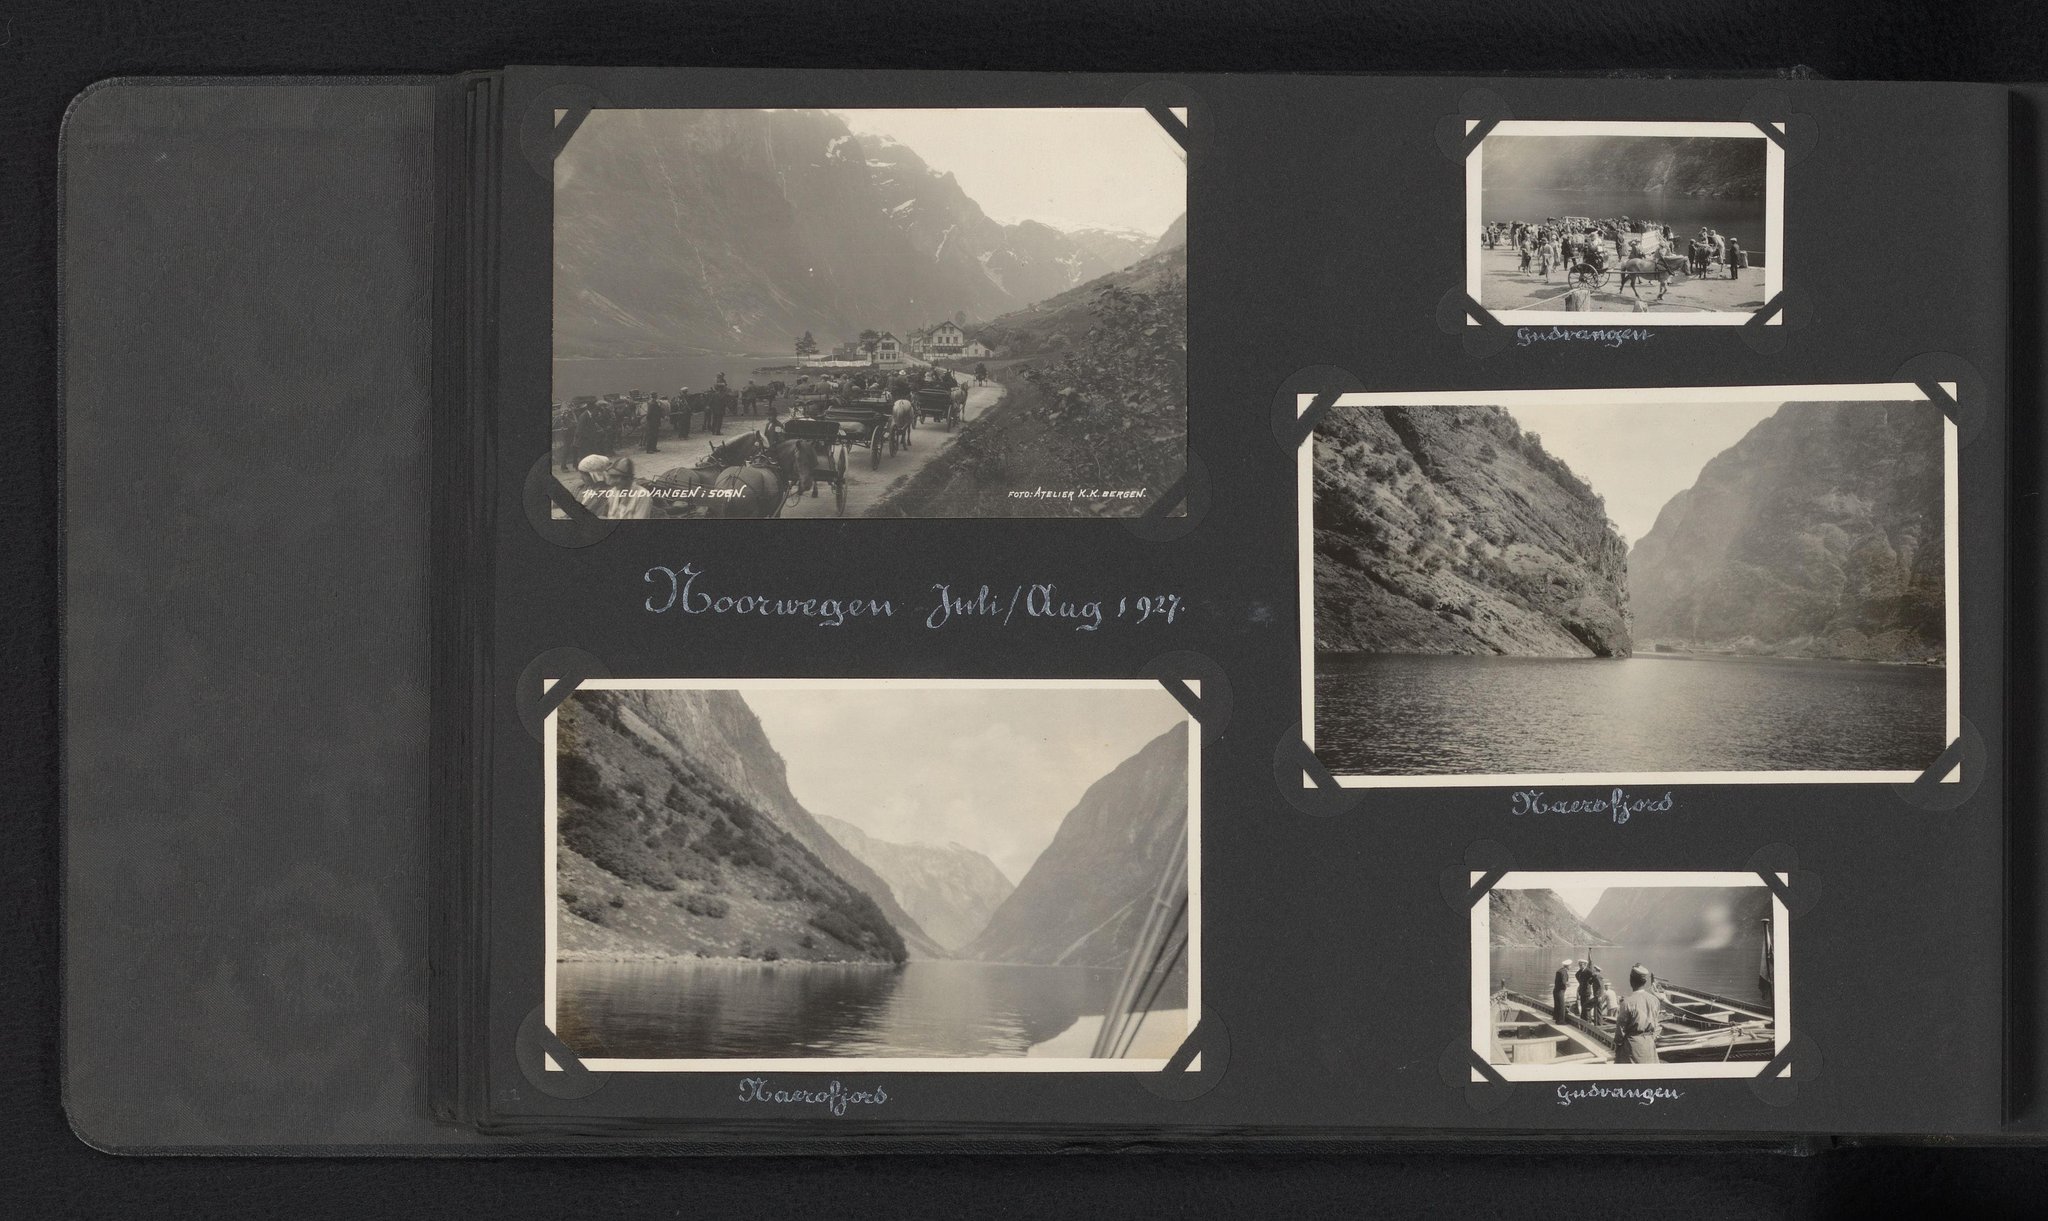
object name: album leaf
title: Vijf foto's, waarvan één prentbriefkaart, van Gudvangen en het Nærøyfjord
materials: paper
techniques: gelatin silver print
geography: norway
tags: fjord, sea loch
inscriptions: inscription: ‘Gudvangen’, inscription: ‘Gudvangen’, inscription: ‘Naerofjord’, inscription: ‘Naerofjord’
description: Deze foto's maken deel uit van een album.